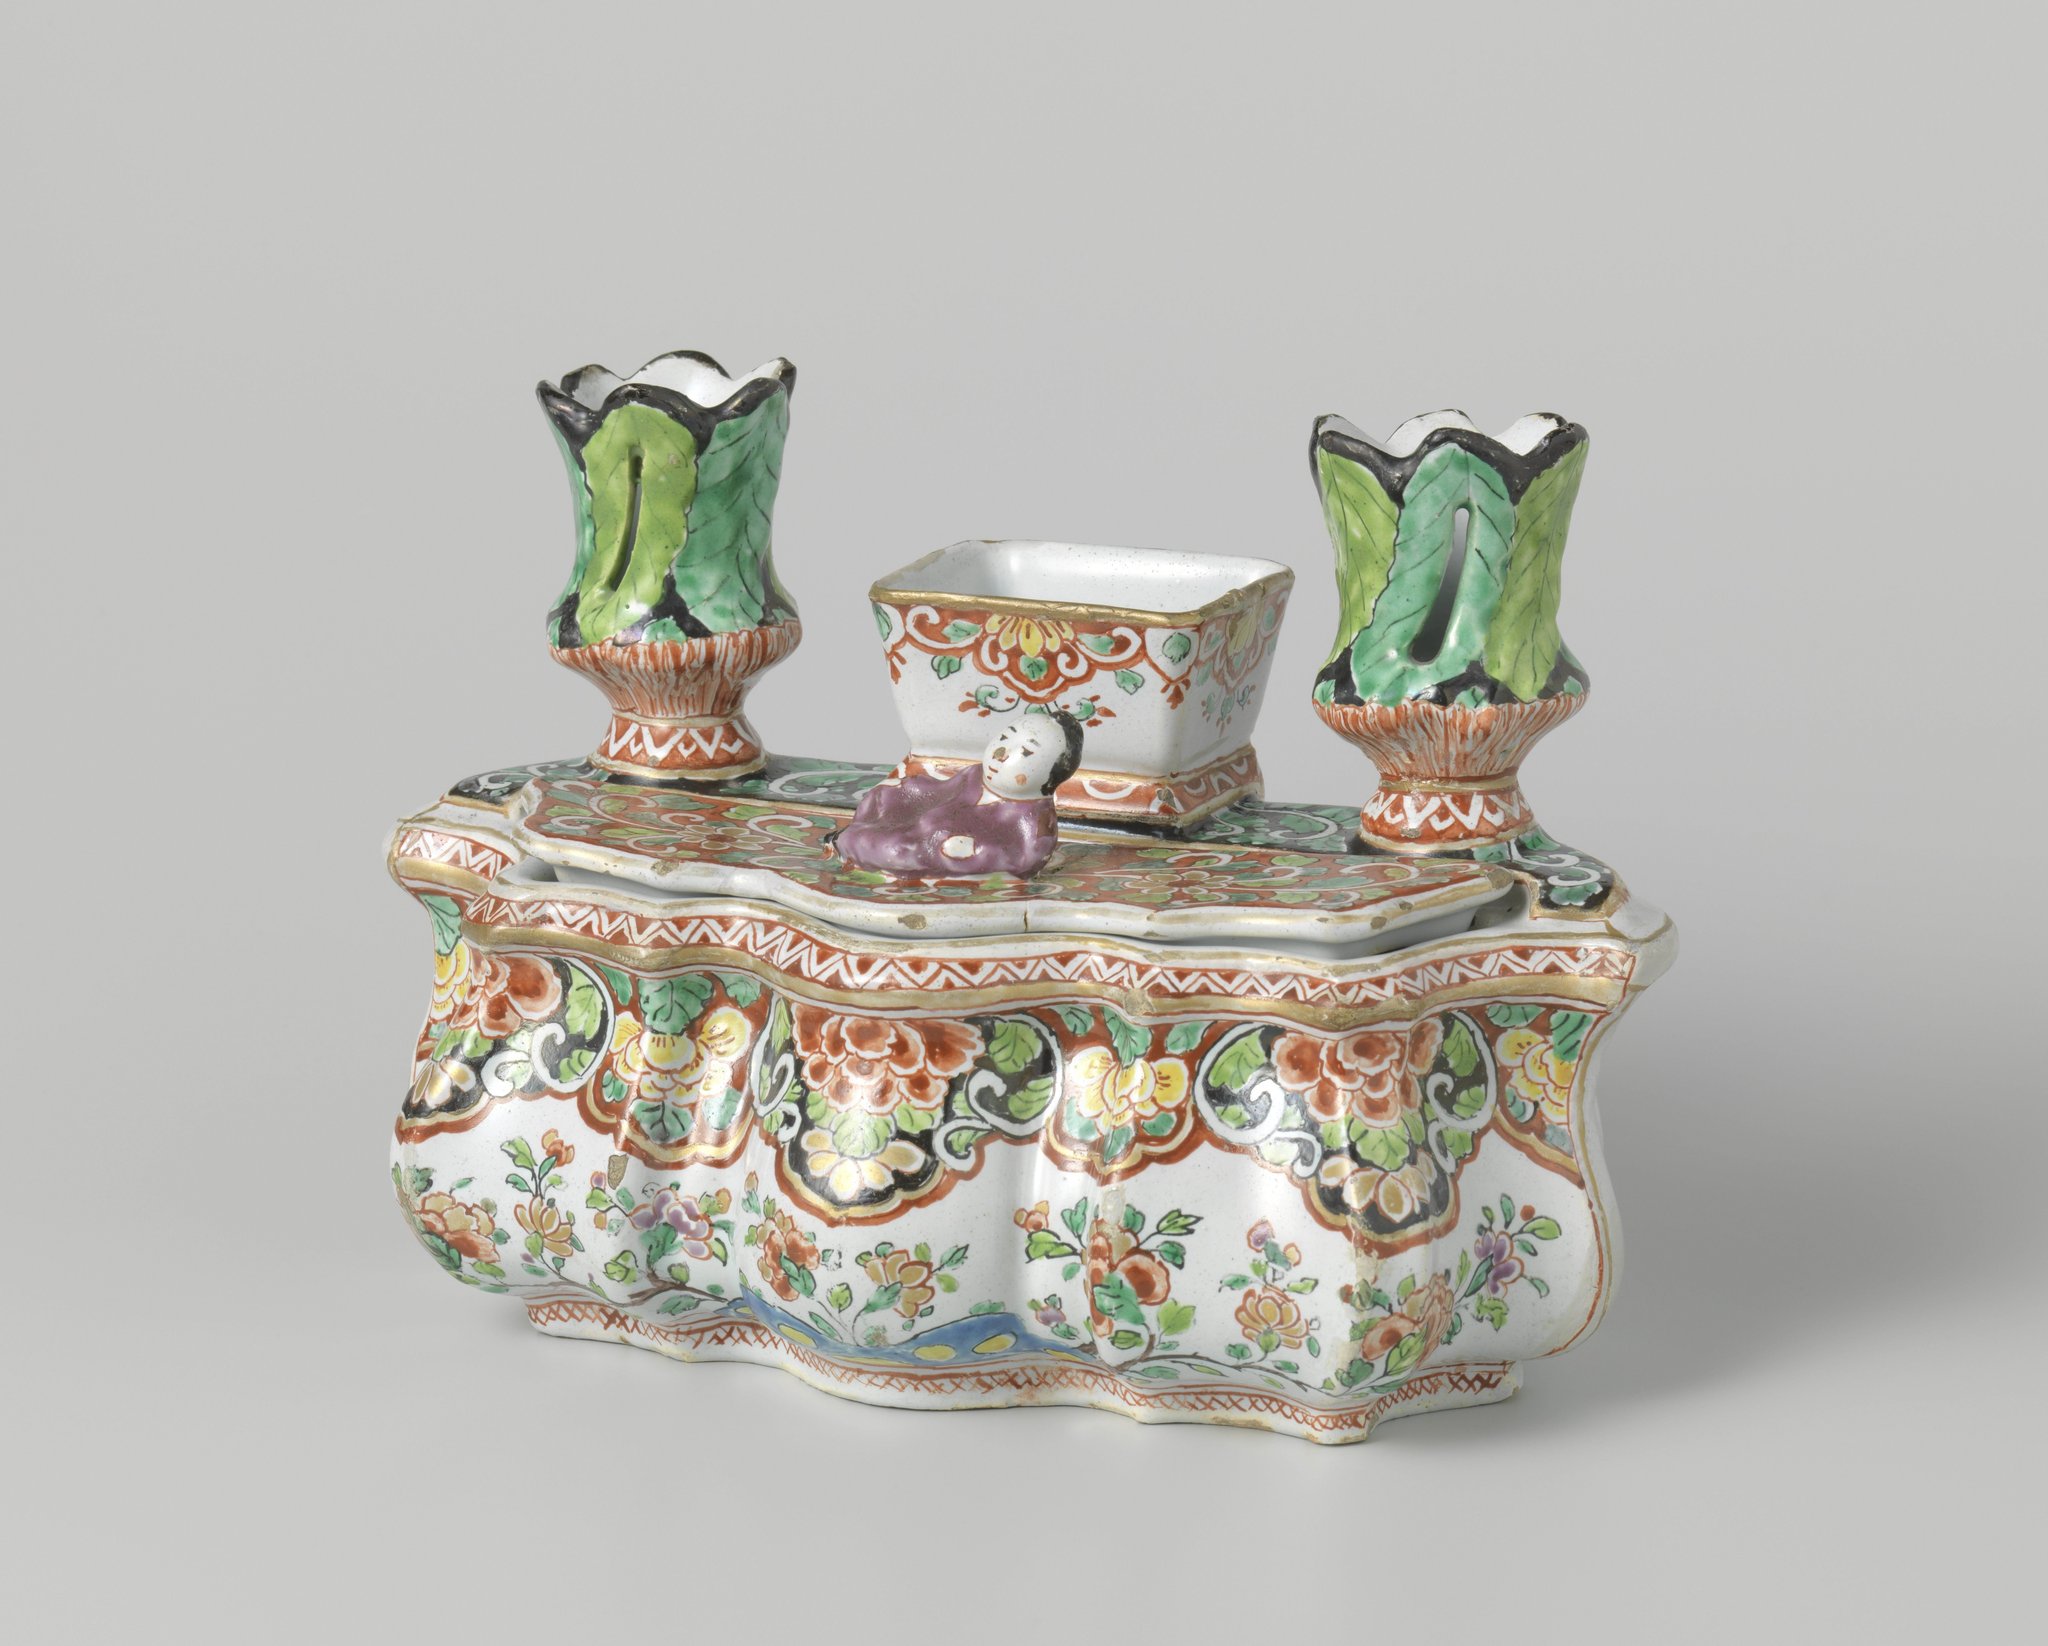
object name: inkstand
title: Inktstel van veelkleurig beschilderde faïence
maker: Anonymous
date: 1750-1775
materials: faience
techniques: kiln, painted, polychromy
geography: delft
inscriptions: collector's mark: ‘collection J.F. Loudon’